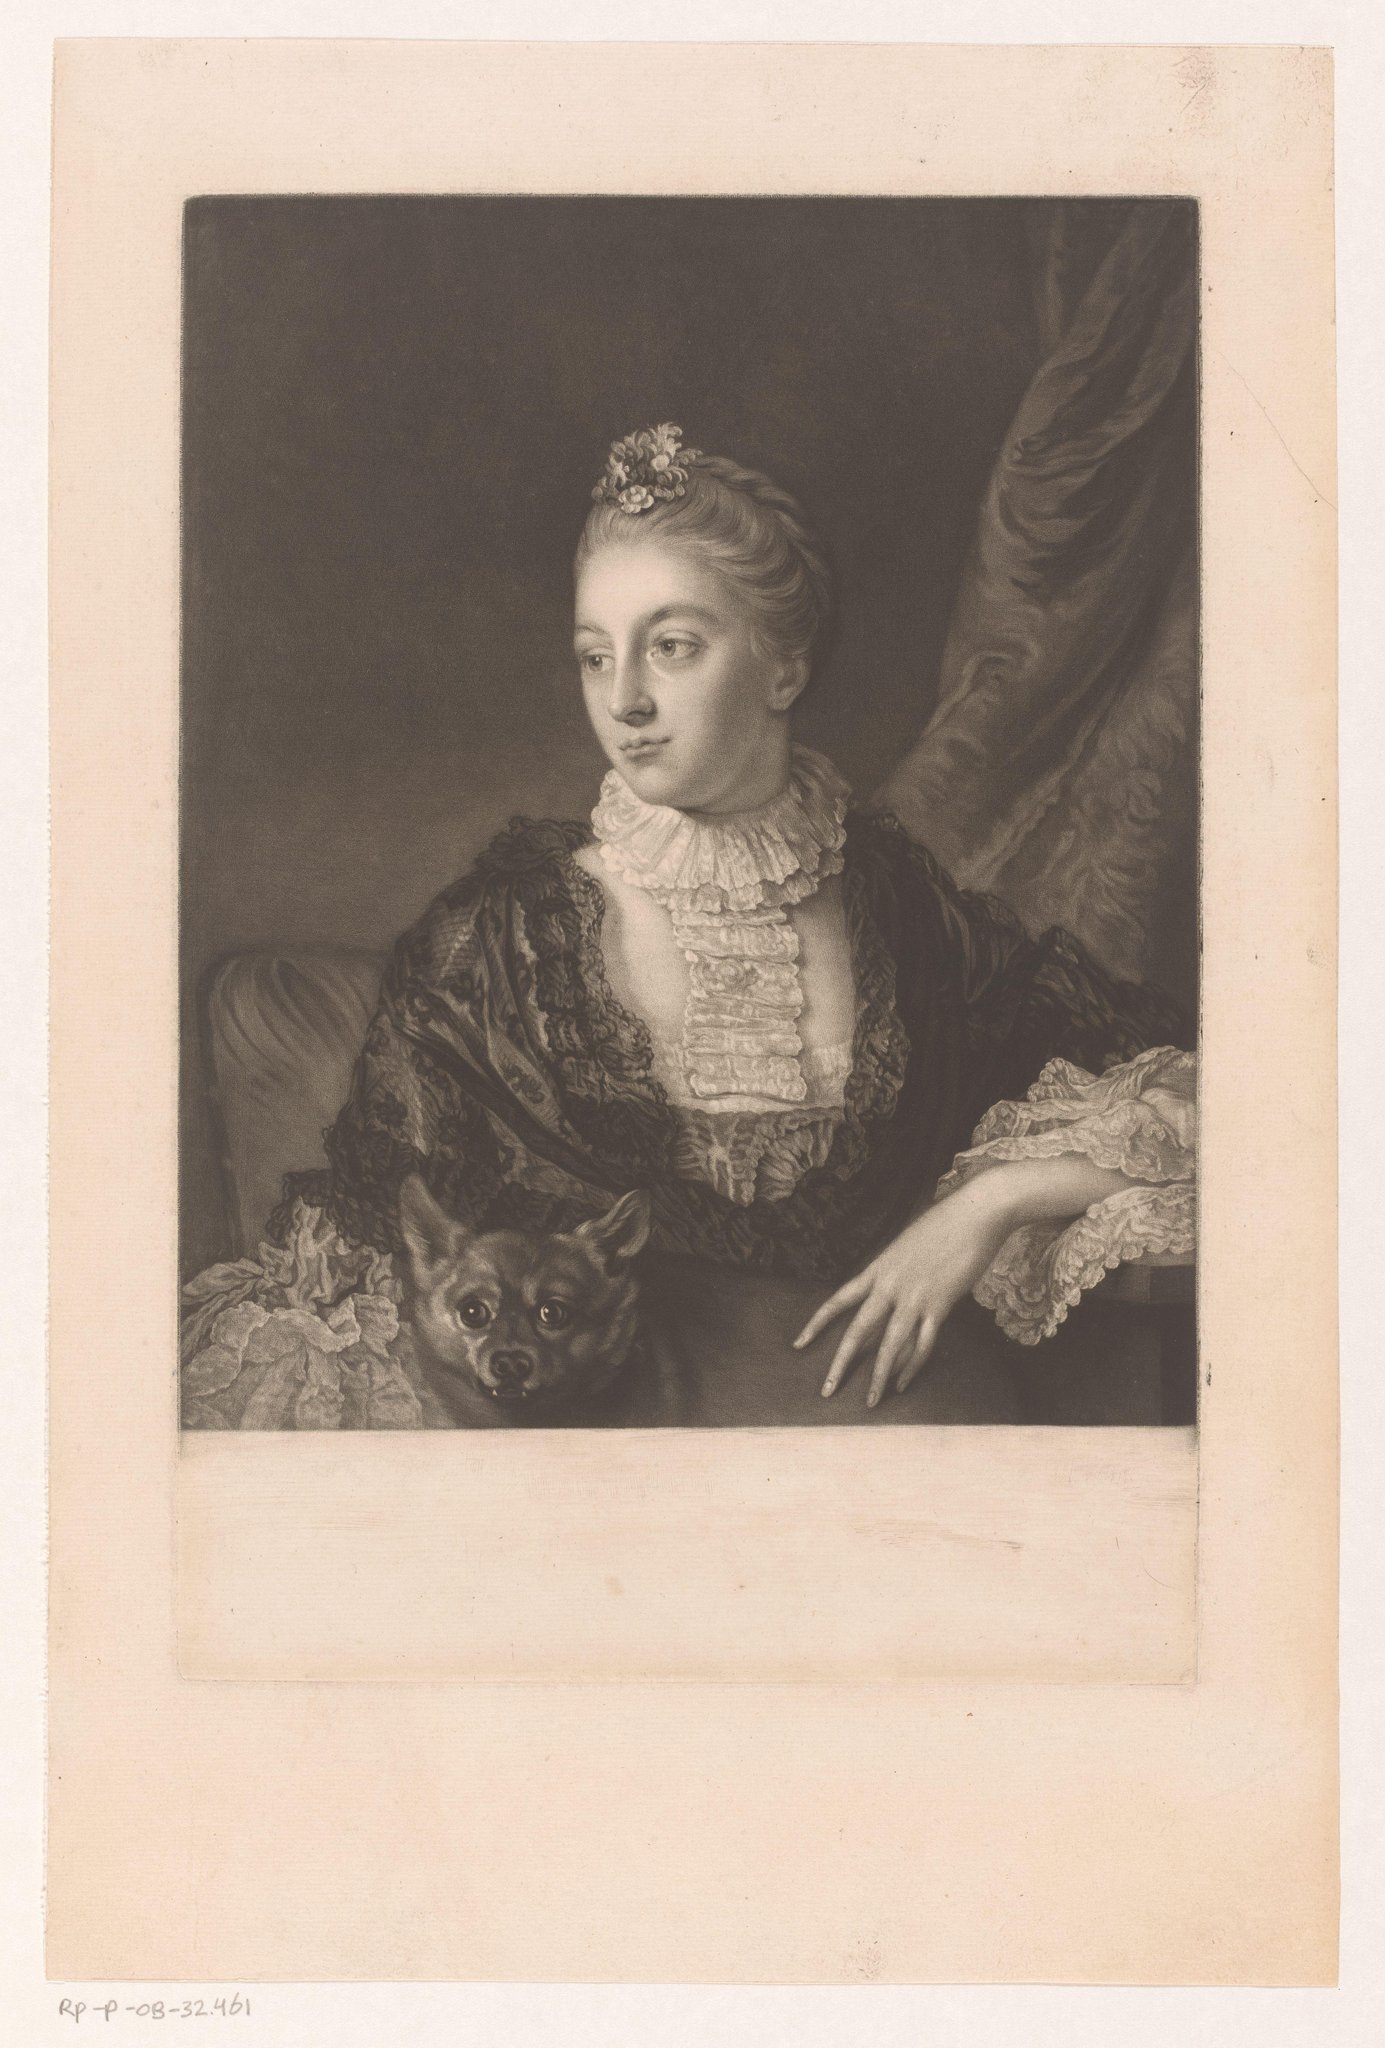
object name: print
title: Portret van Louisa Lennox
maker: james mcardell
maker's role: print maker, publisher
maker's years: 1728-1765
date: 1759-1765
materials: paper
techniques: mezzotint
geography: london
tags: historical persons - bb - woman, dog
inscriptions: collector's mark: Lugt 240